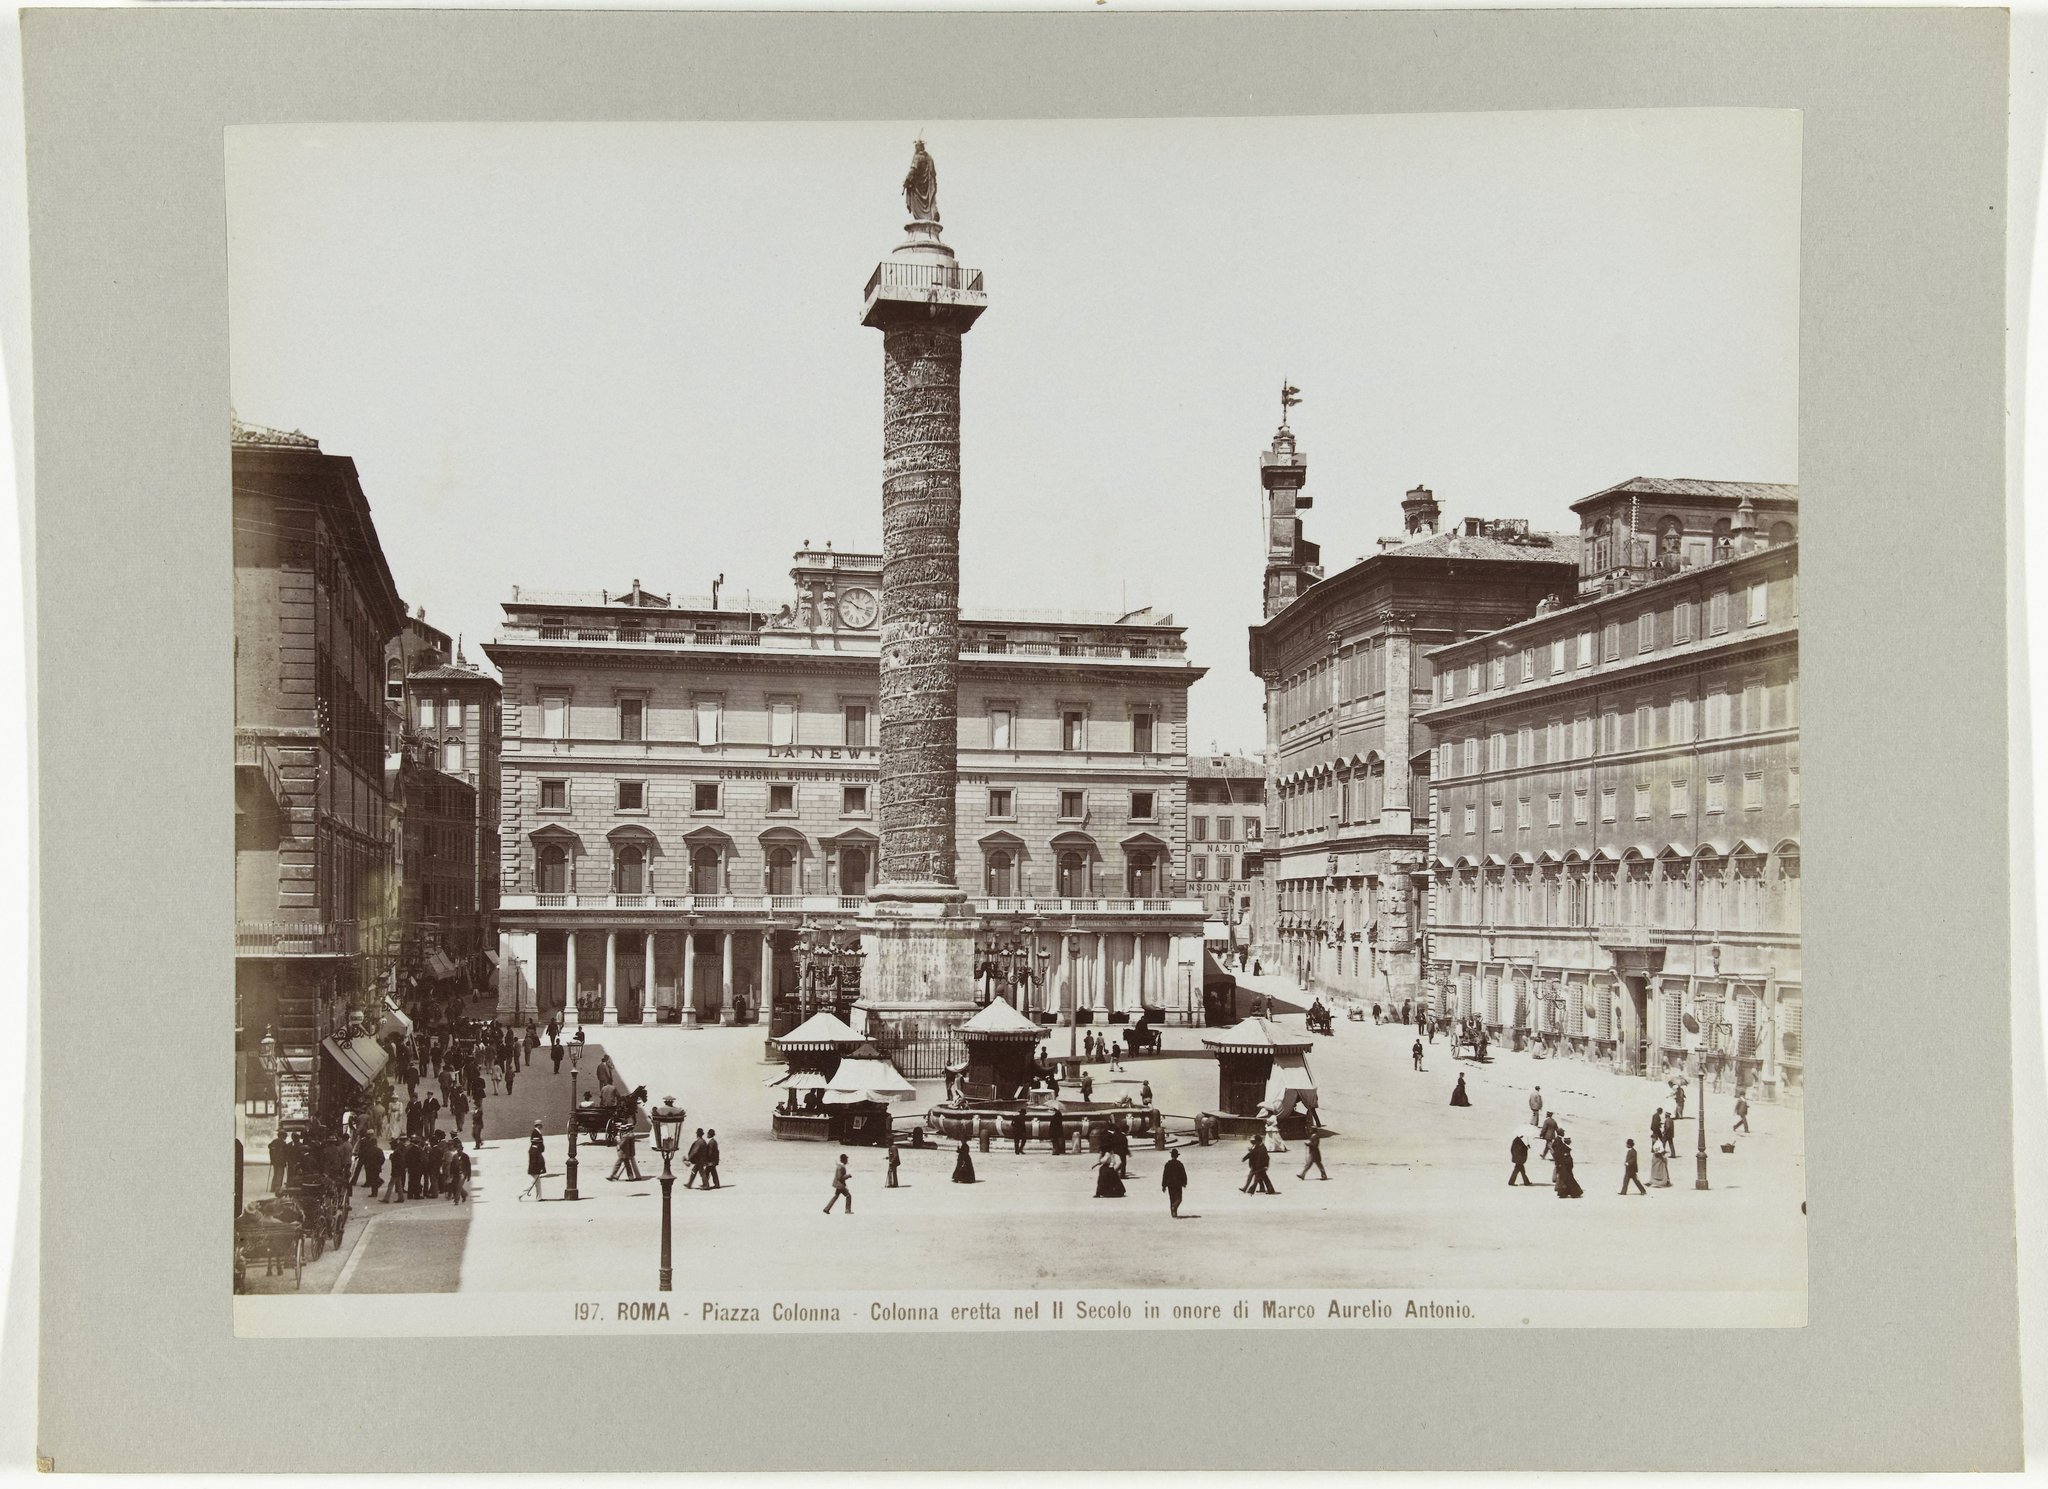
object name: photograph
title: 197. Roma - Piazza Colonna - Colonna eretta nel II Secolo in onore di Marco Aurelio Antonie.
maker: Anonymous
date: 1880-1904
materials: cardboard, paper, photographic support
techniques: albumen print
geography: rome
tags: zuil van marcus aurelius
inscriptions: number: ‘30.’